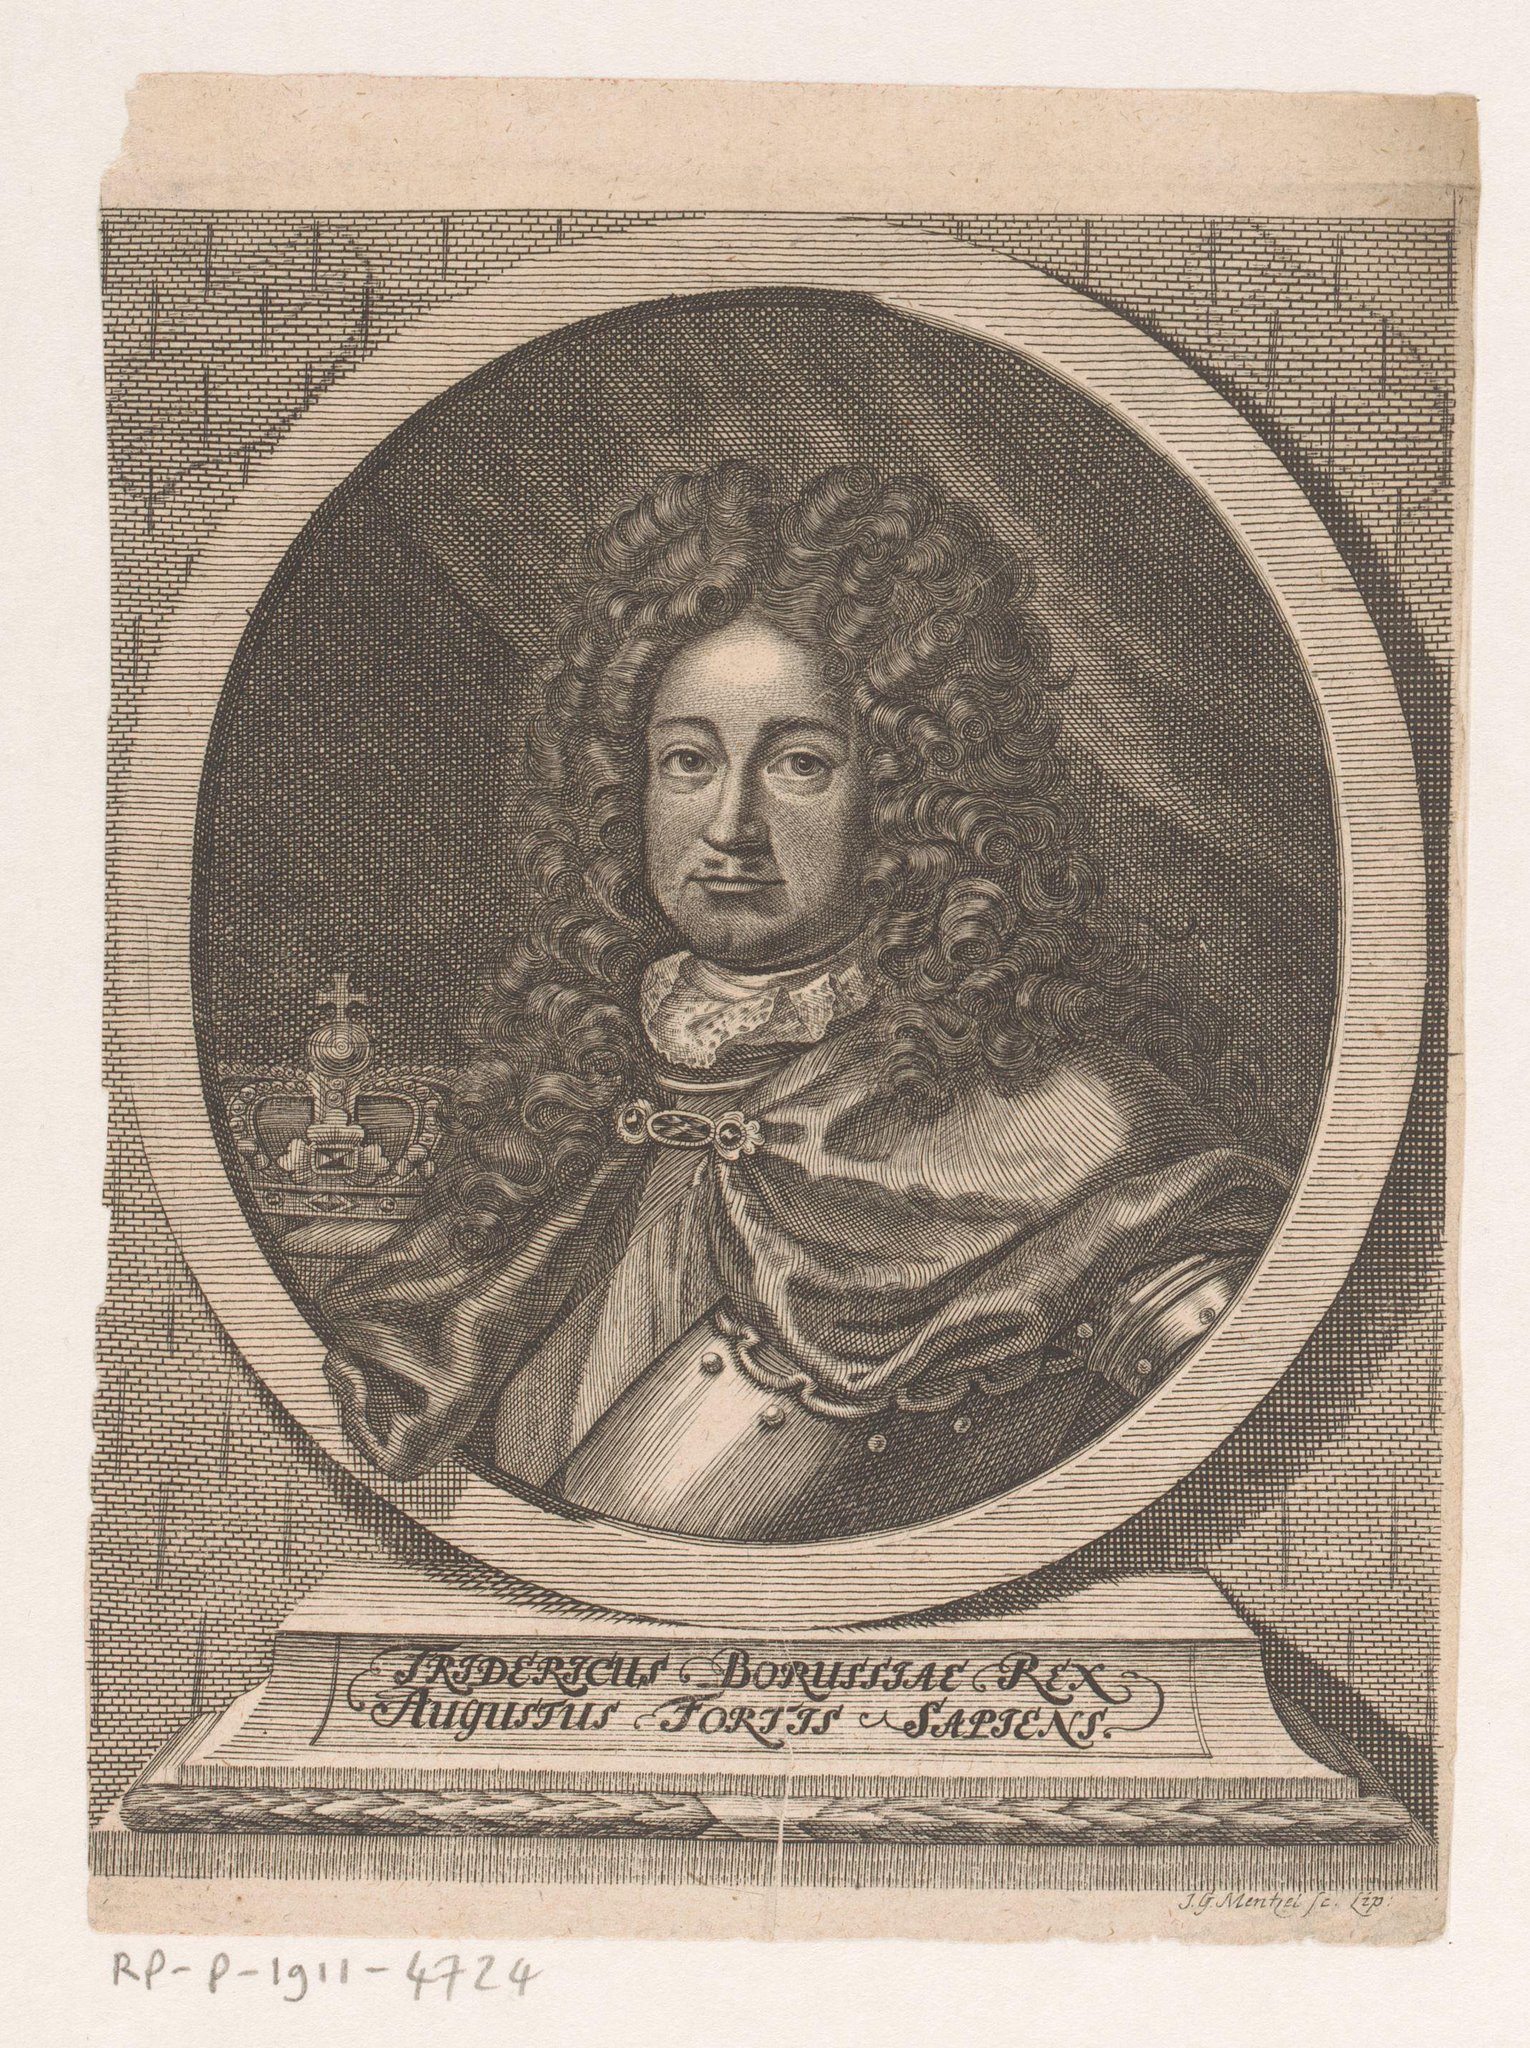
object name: print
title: Portret van koning Frederik I van Pruisen keurvorst van Brandenburg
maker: johann georg mentzel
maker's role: print maker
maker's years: 1677-1743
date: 1687-1743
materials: paper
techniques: engraving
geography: leipzig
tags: armour, historical persons, wig, armorial bearing, heraldry, insignia and symbols of sovereignty (crown, diadem, sceptre, orb, seal, standard, cloak, pectoral)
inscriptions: collector's mark: Lugt 2228